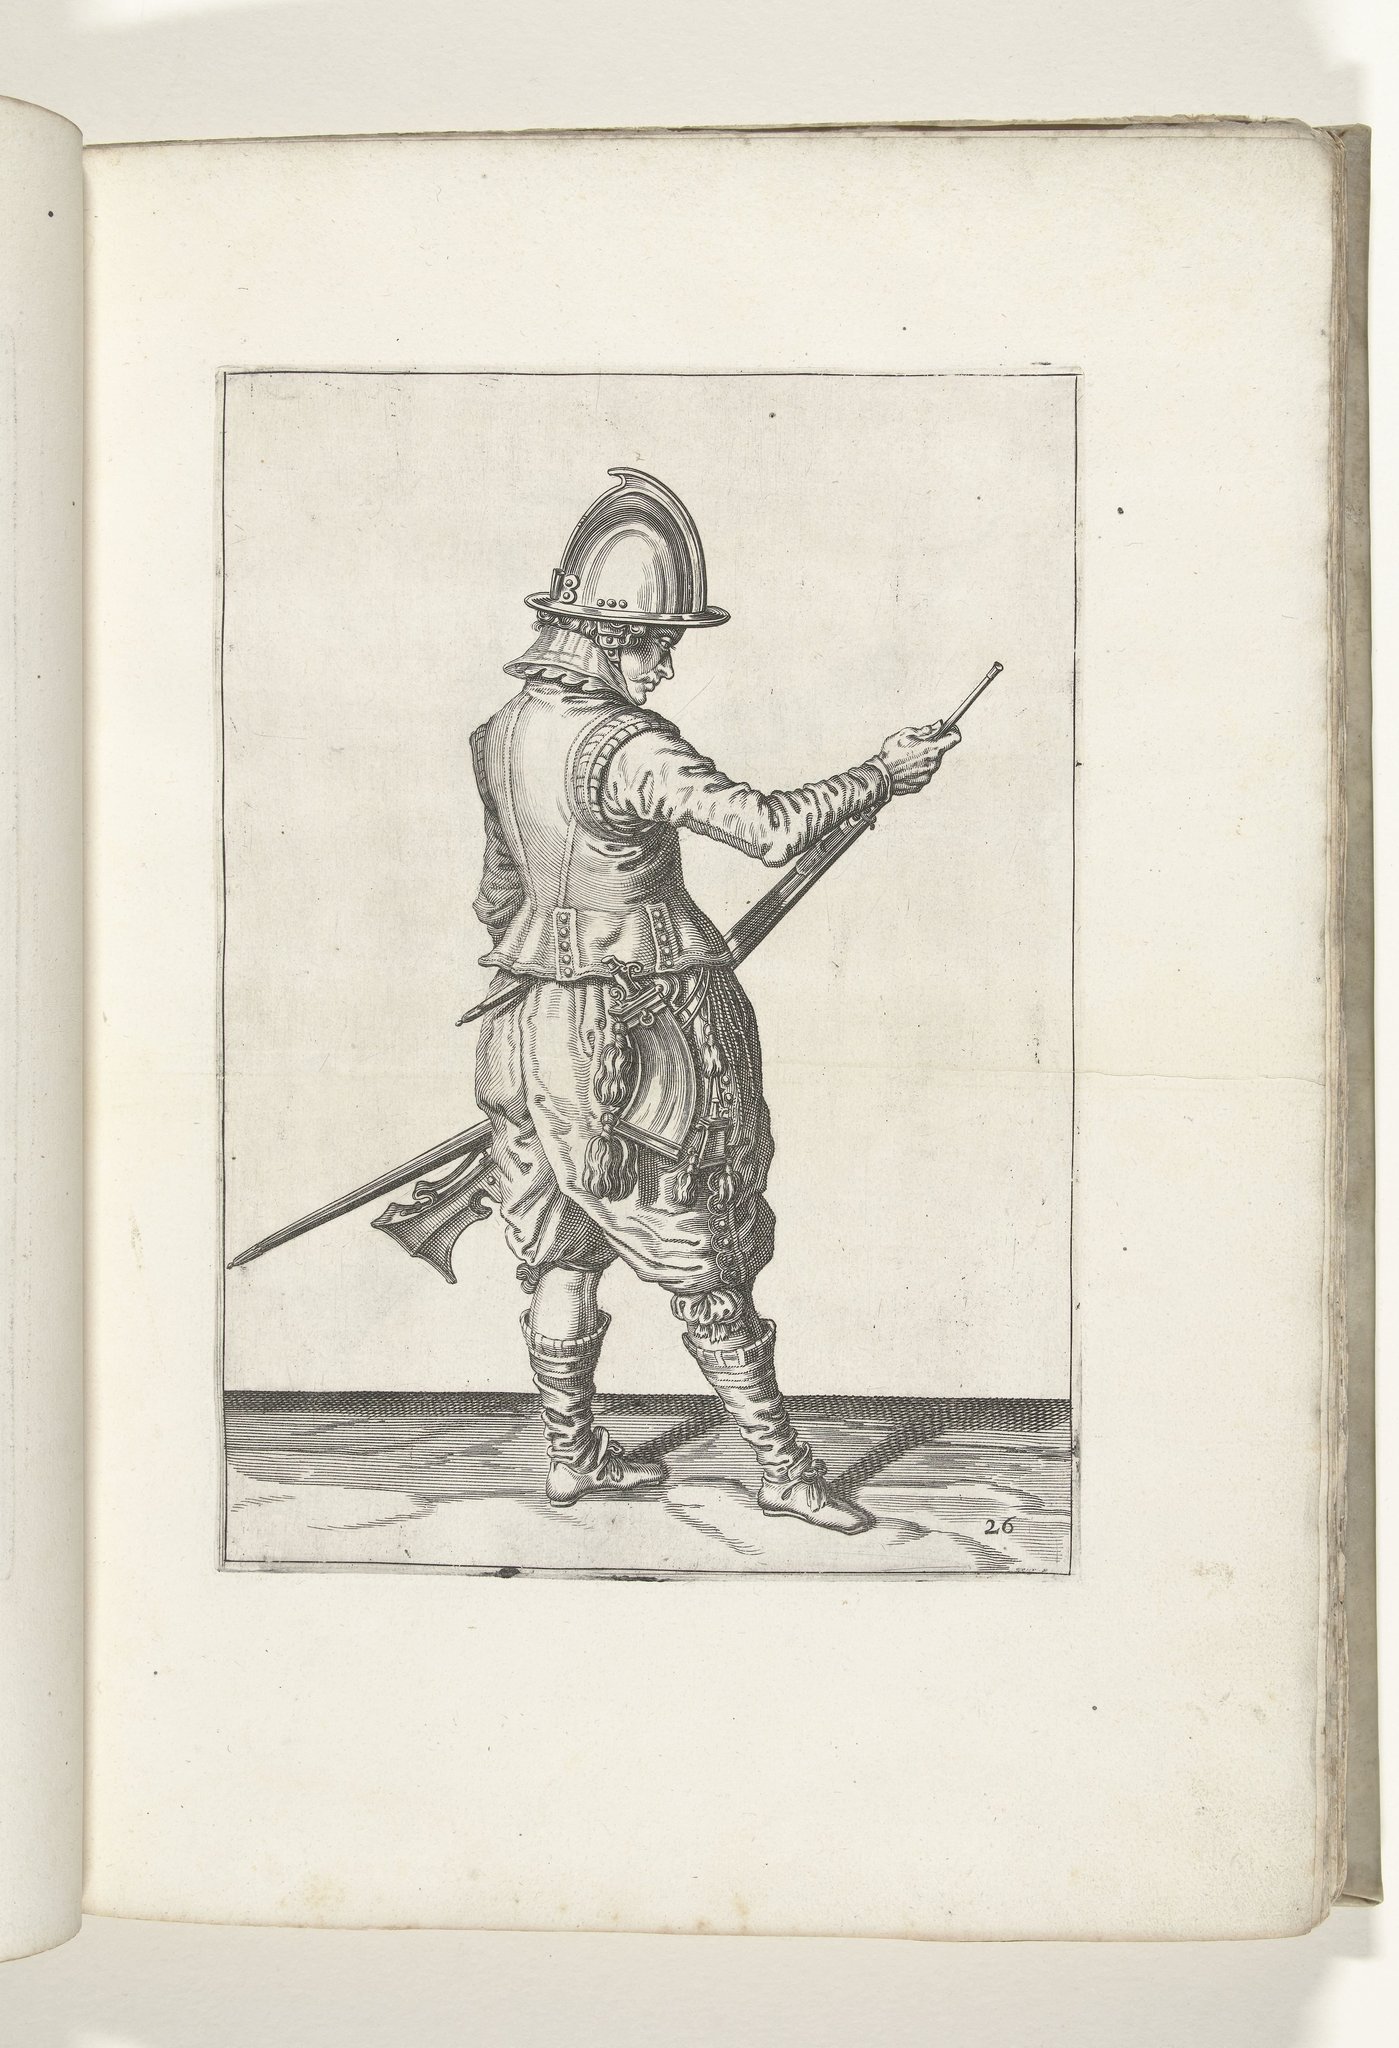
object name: print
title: Soldaat die met zijn laadstok kruit en kogel in de loop van zijn roer duwt (nr. 26), ca. 1600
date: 1597-1607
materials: paper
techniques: engraving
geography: northern netherlands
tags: maurice (prince of orange), handling of weapons ~ military training, weapons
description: Een soldaat, ten voeten uit, naar rechts, die met zijn linkerhand bij zijn linkerdijbeen een roer (een bepaald type vuurwapen) vasthoudt en met zijn rechterhand zijn laadstok in de loop brengt, om kruit en kogel aan te duwen (nr. 26), ca. 1600. Plaat 26 in de instructies voor het hanteren van de roer: Corte onderwysinghe op de figuerliicke afbeeldinghe, belanghende t'rechte ghebruyck des Roers. Onderdeel van de illustraties in: J. de Gheyn, Wapenhandelinghe van Roers Musquetten ende spiessen, 's-Gravenhage, 1607. Krijgswezen rond 1600.